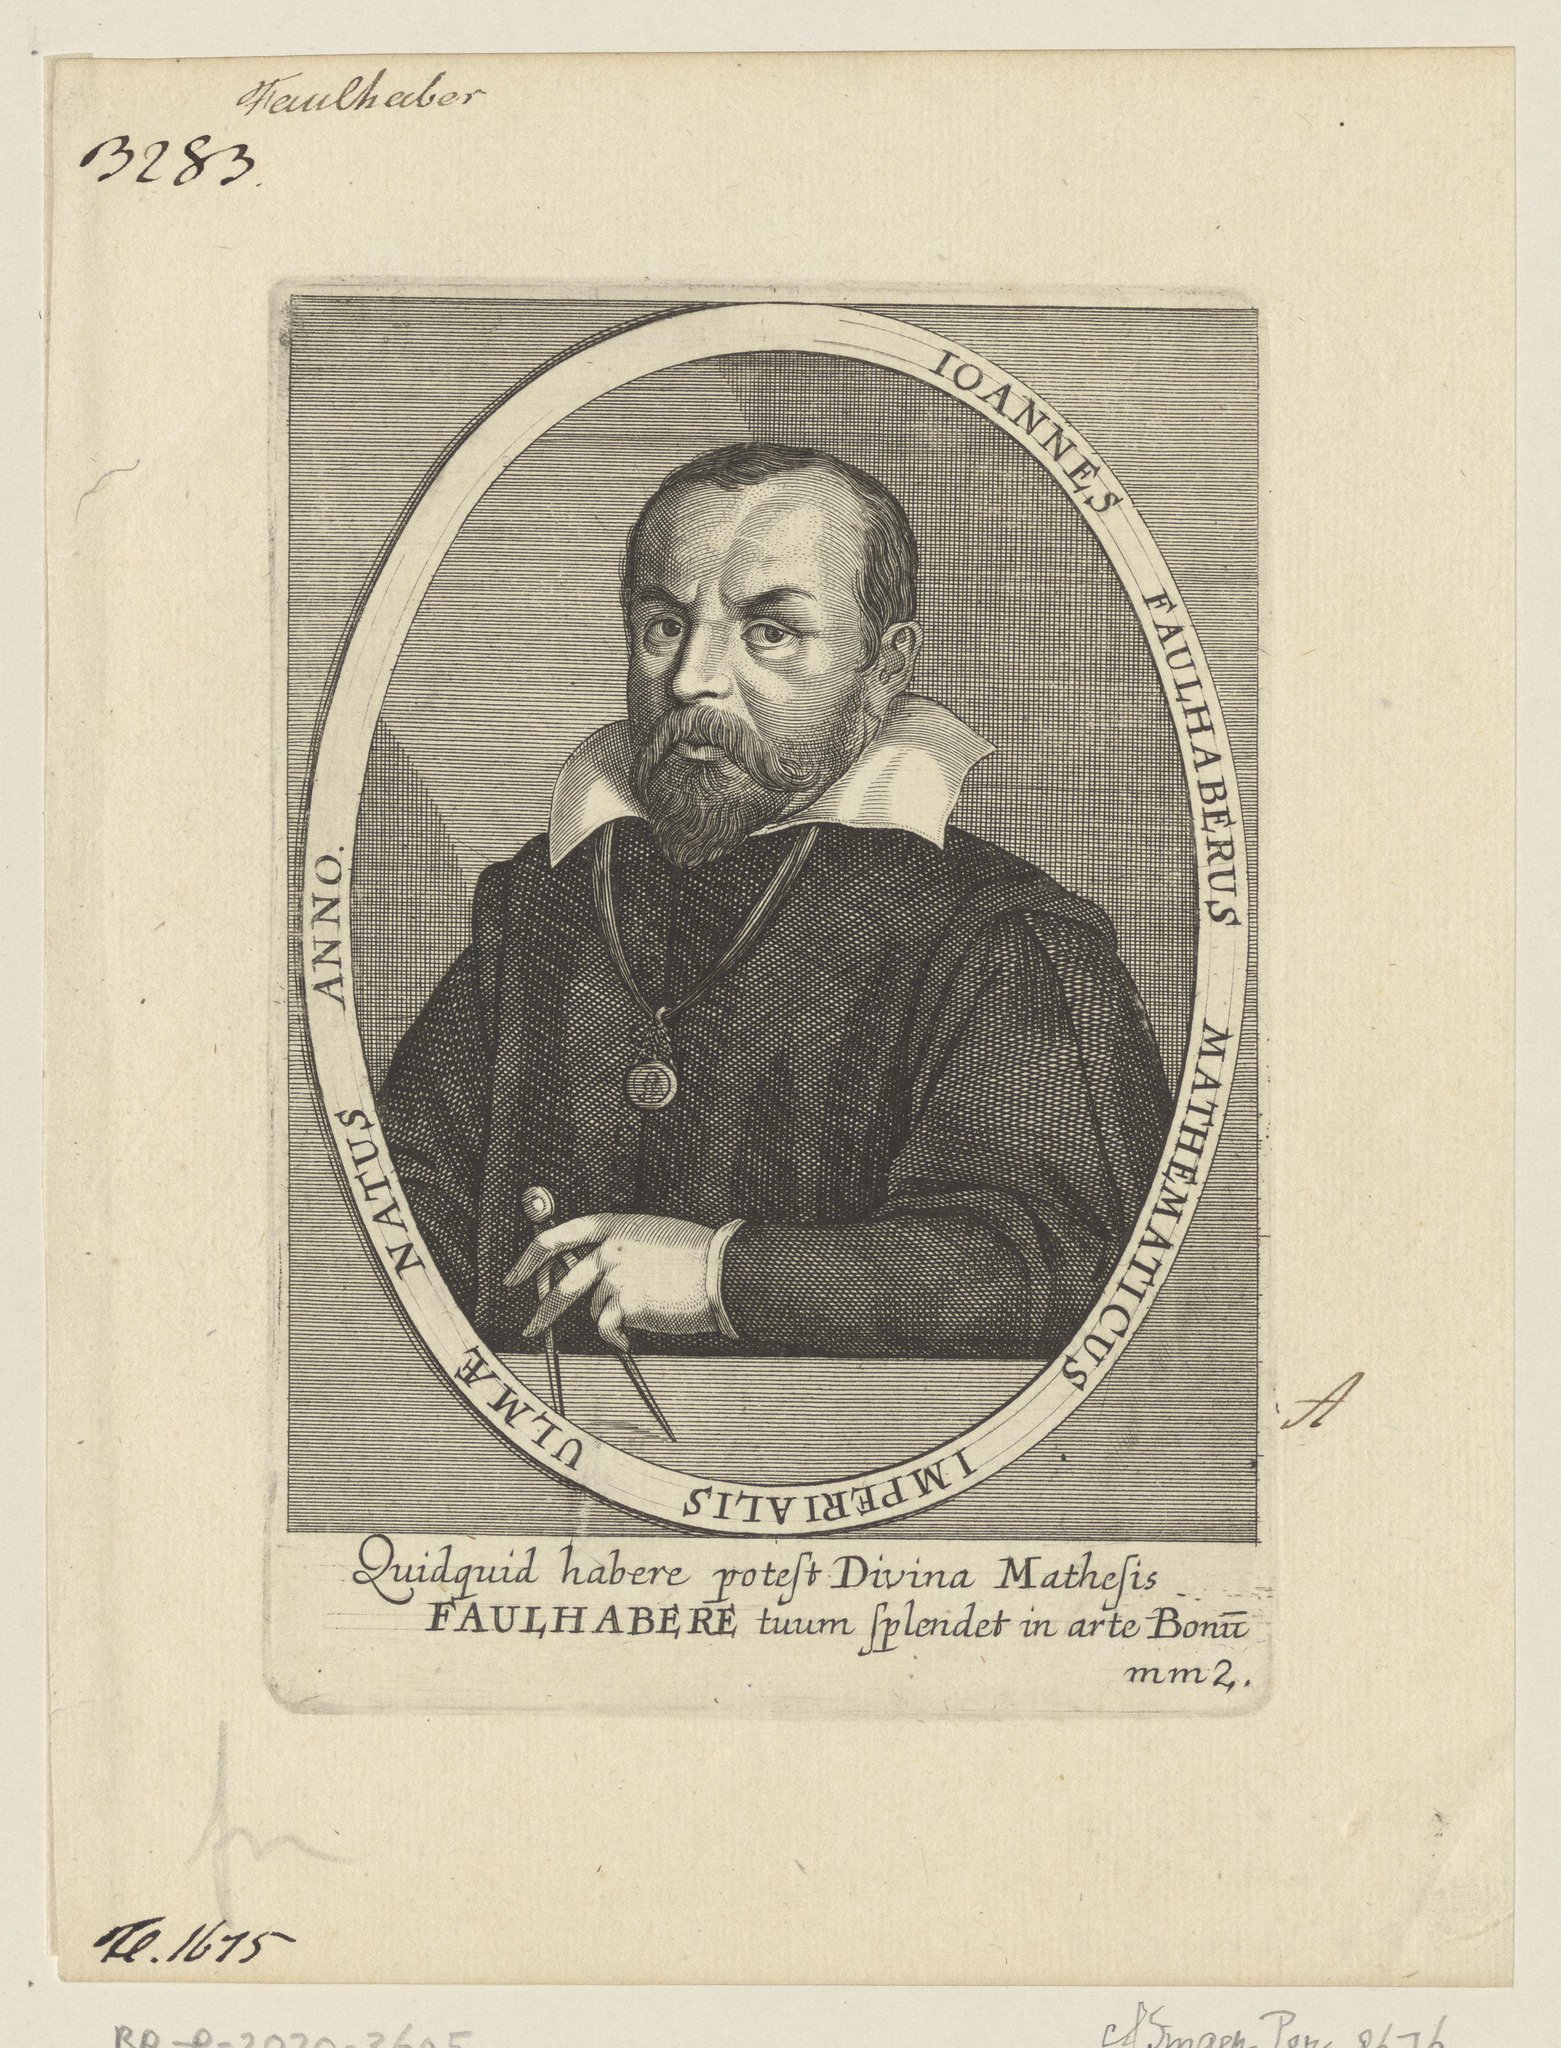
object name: print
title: Portretten van geleerden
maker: Anonymous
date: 1650-1652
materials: paper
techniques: engraving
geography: germany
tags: engineer, historical persons, compasses, mathematics (+ portrait of scholar, scientist)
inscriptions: inscription: ‘[...]1615’, inscription: ‘A’, inscription: ‘Feulhaber/ 13283’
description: Prent waarschijnlijk uit een deel van: Boissard, Jean Jacques. Bibliotheca chalcographica (...). Frankfurt am Main: Johannes Ammon, 1650-1652.